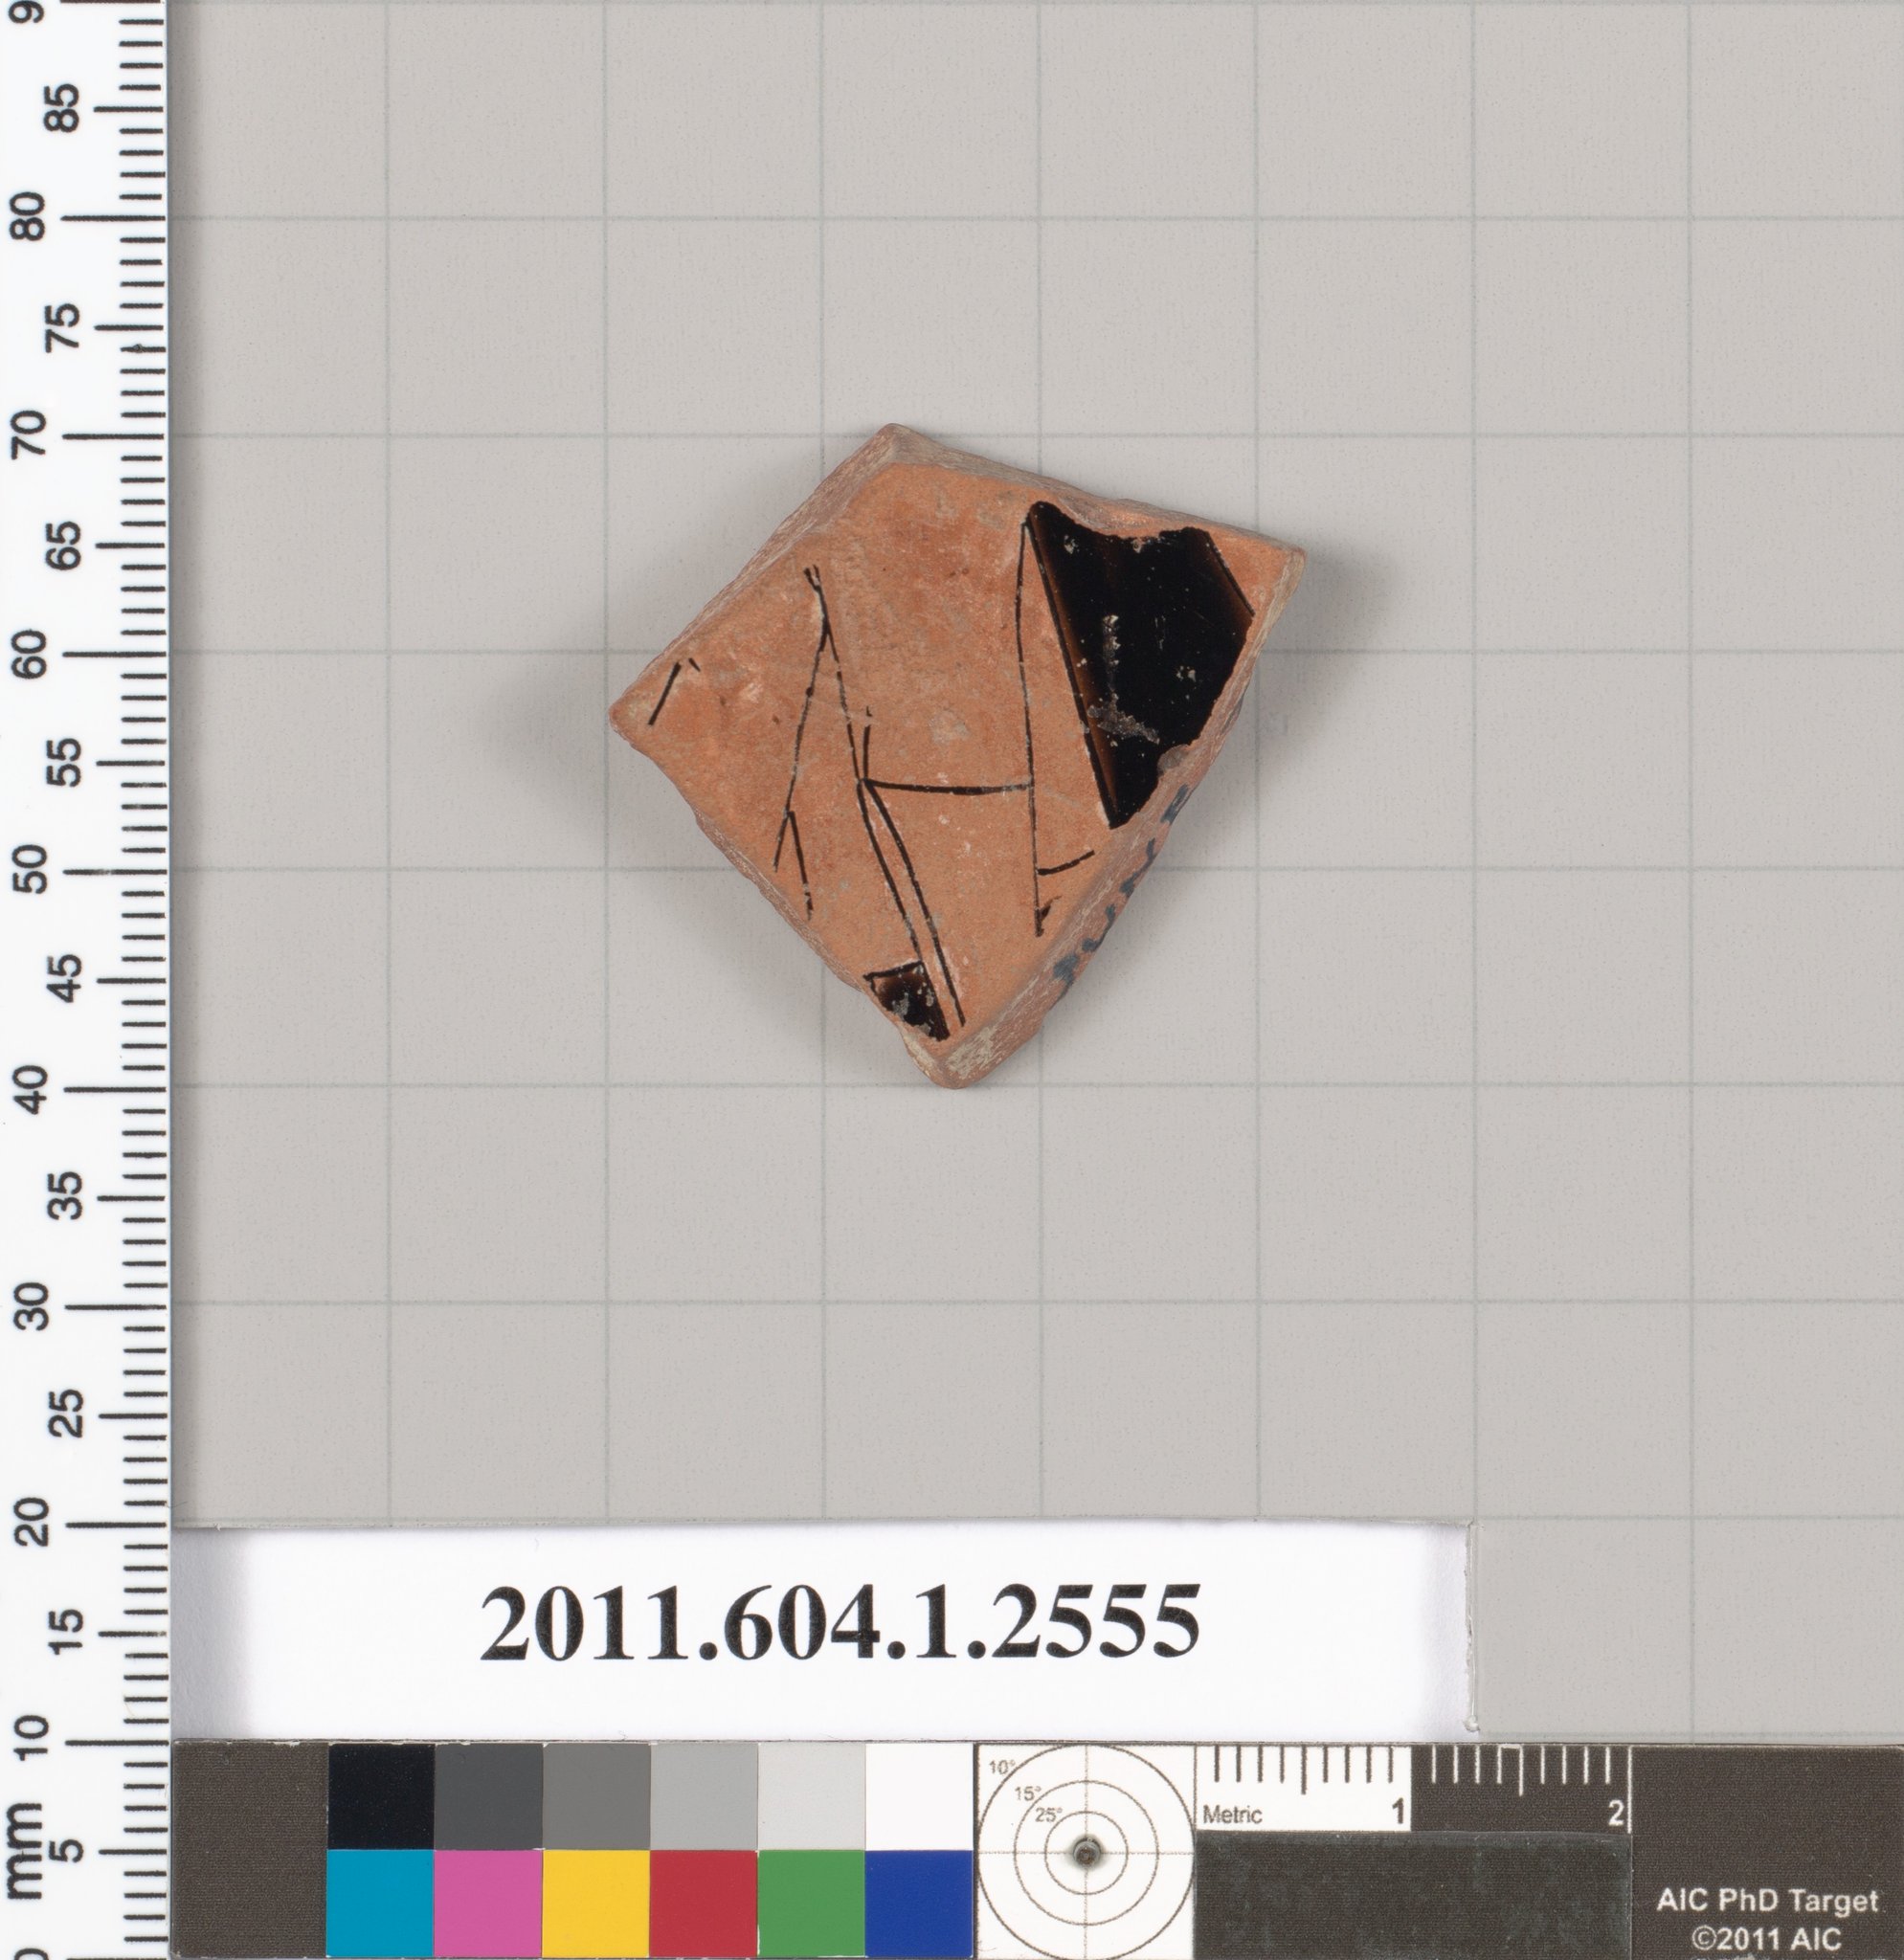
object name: kylix fragment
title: Terracotta fragment of a kylix (drinking cup)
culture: greek, attic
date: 475-451 BCE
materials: terracotta